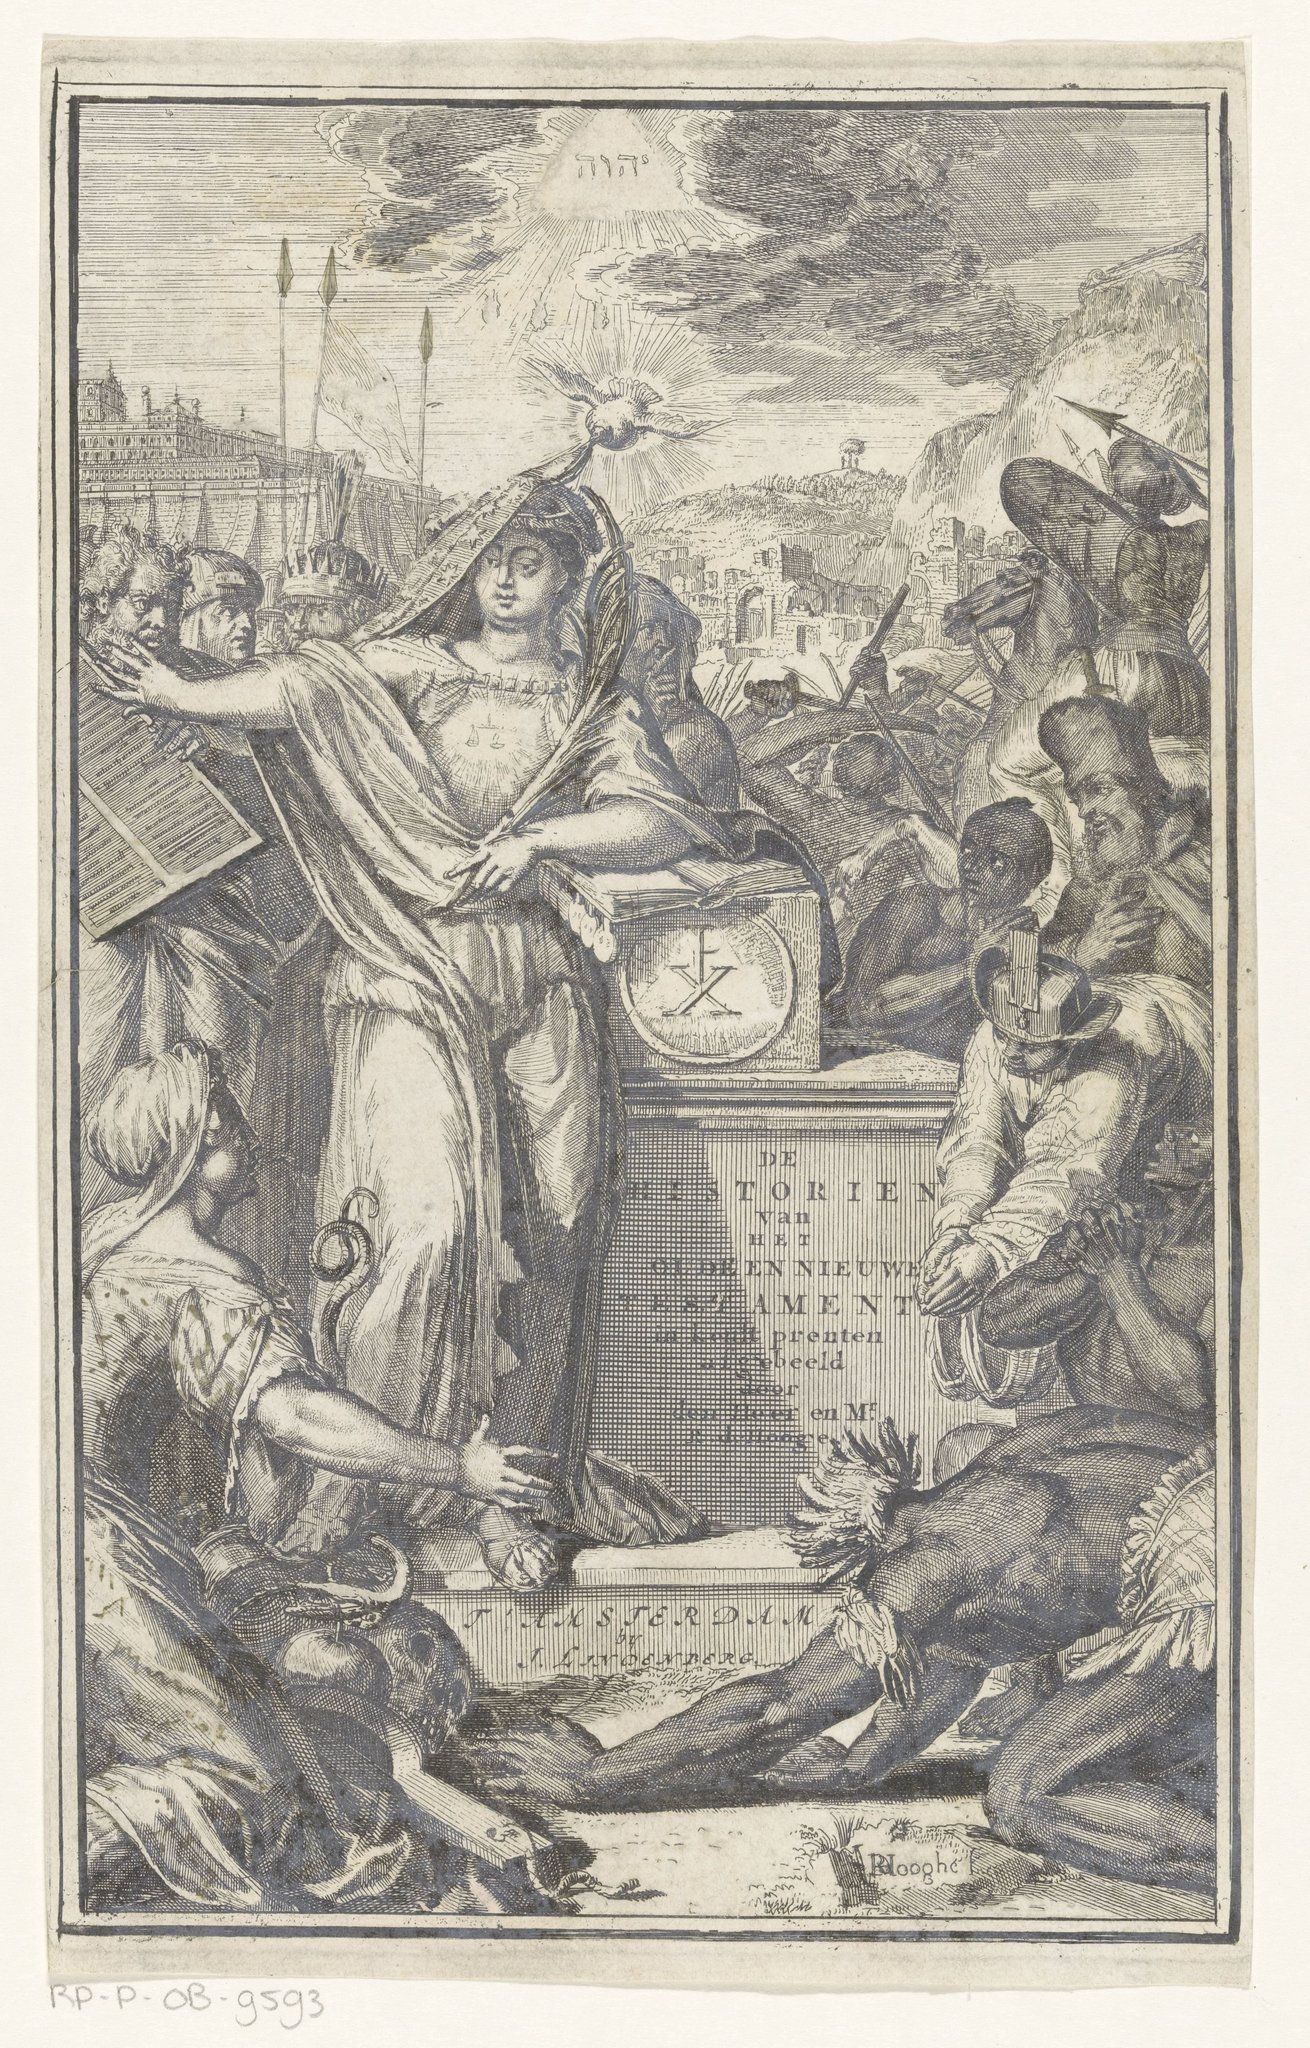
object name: titelblad, titelpagina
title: Allegorie op het oude en nieuwe testament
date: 1703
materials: paper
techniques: etching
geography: amsterdam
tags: moses (not in biblical context); possible attributes: rays of light or horns on his head, rod, tables of the law, triangle (within circle), with eye or tetragram ~ trinity, old testament and new testament compared, holy ghost represented as a dove (in flames)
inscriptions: collector's mark: Lugt 2228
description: Een allegorische vrouwenfiguur met weegschaal op de borst en palmtak in de hand staat leunend op een boek tegen een voetstuk met de titel van het boek. Met haar rechtervoet vertrapt zij een slang. Links van haar staat Mozes met de stenen tafelen. Voor haar zit een geknielde vrouw. Rechts aanbiddende figuren van diverse afkomst. Daarachter vechtende mannen. In de achtergrond de tempel van Salomo, de zondeval en de ark van Noach. Boven de vrouw een duif als symbool van Heilige Geest en het tetragram.